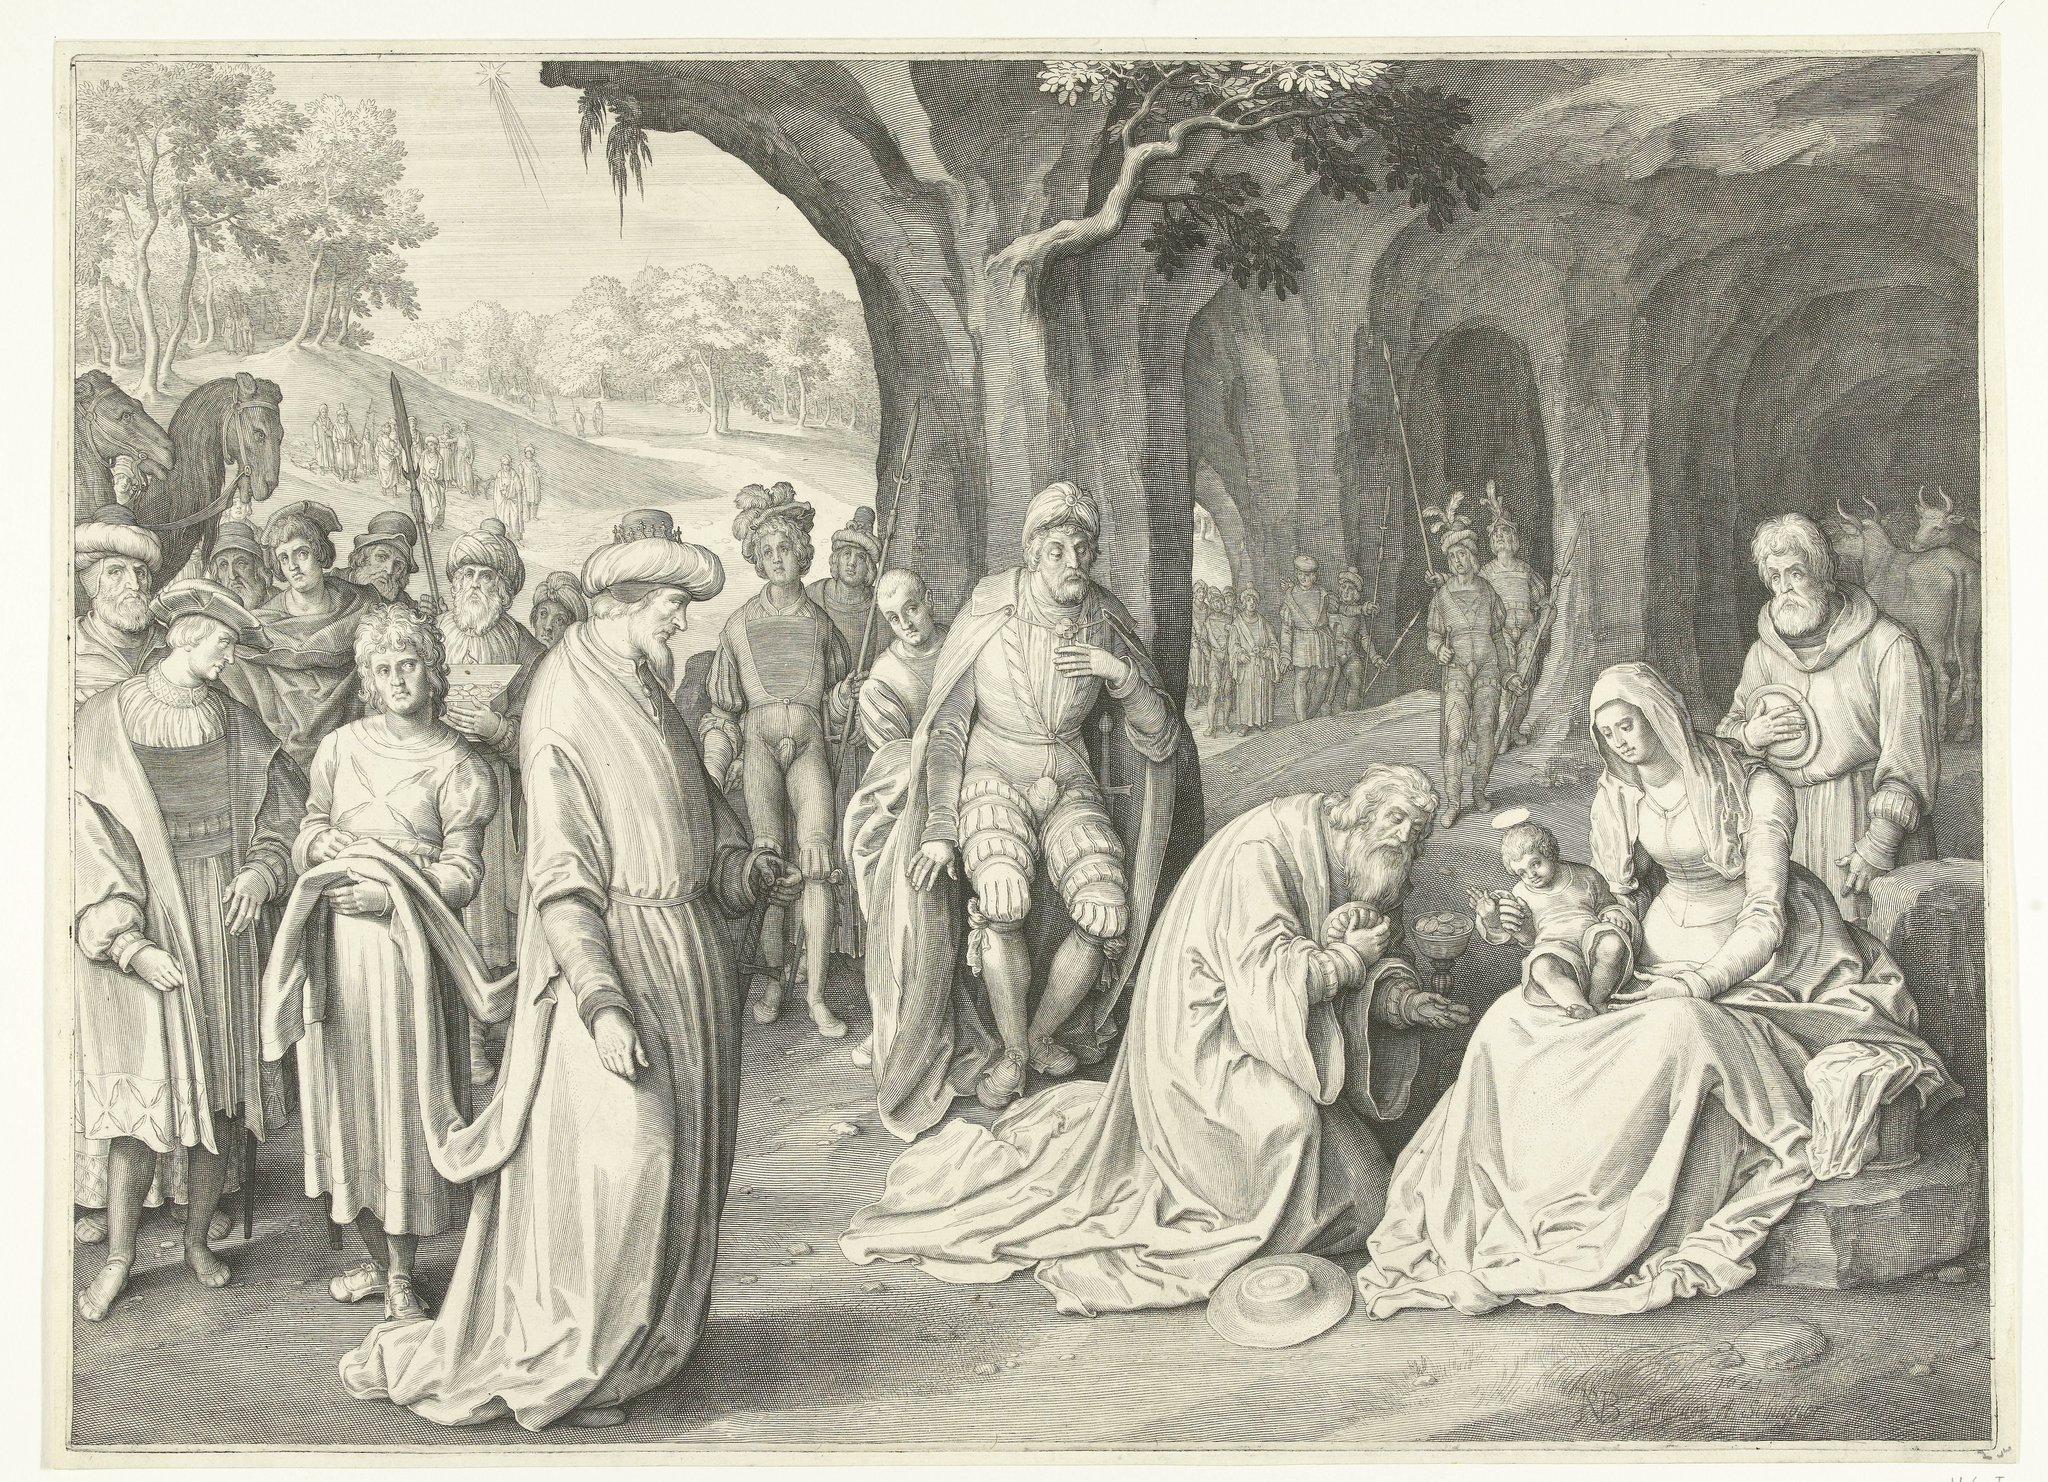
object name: print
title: Aanbidding der koningen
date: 1621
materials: paper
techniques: engraving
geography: netherlands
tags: adoration of the kings: the wise men present their gifts to the christ-child (gold, frankincense and myrrh)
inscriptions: collector's mark:, collector's mark: Lugt 2228, collector's mark: Lugt 2612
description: De compositie van Nicolaes de Bruyn is geïnspireerd door het werk van Hendrick Goltzius.